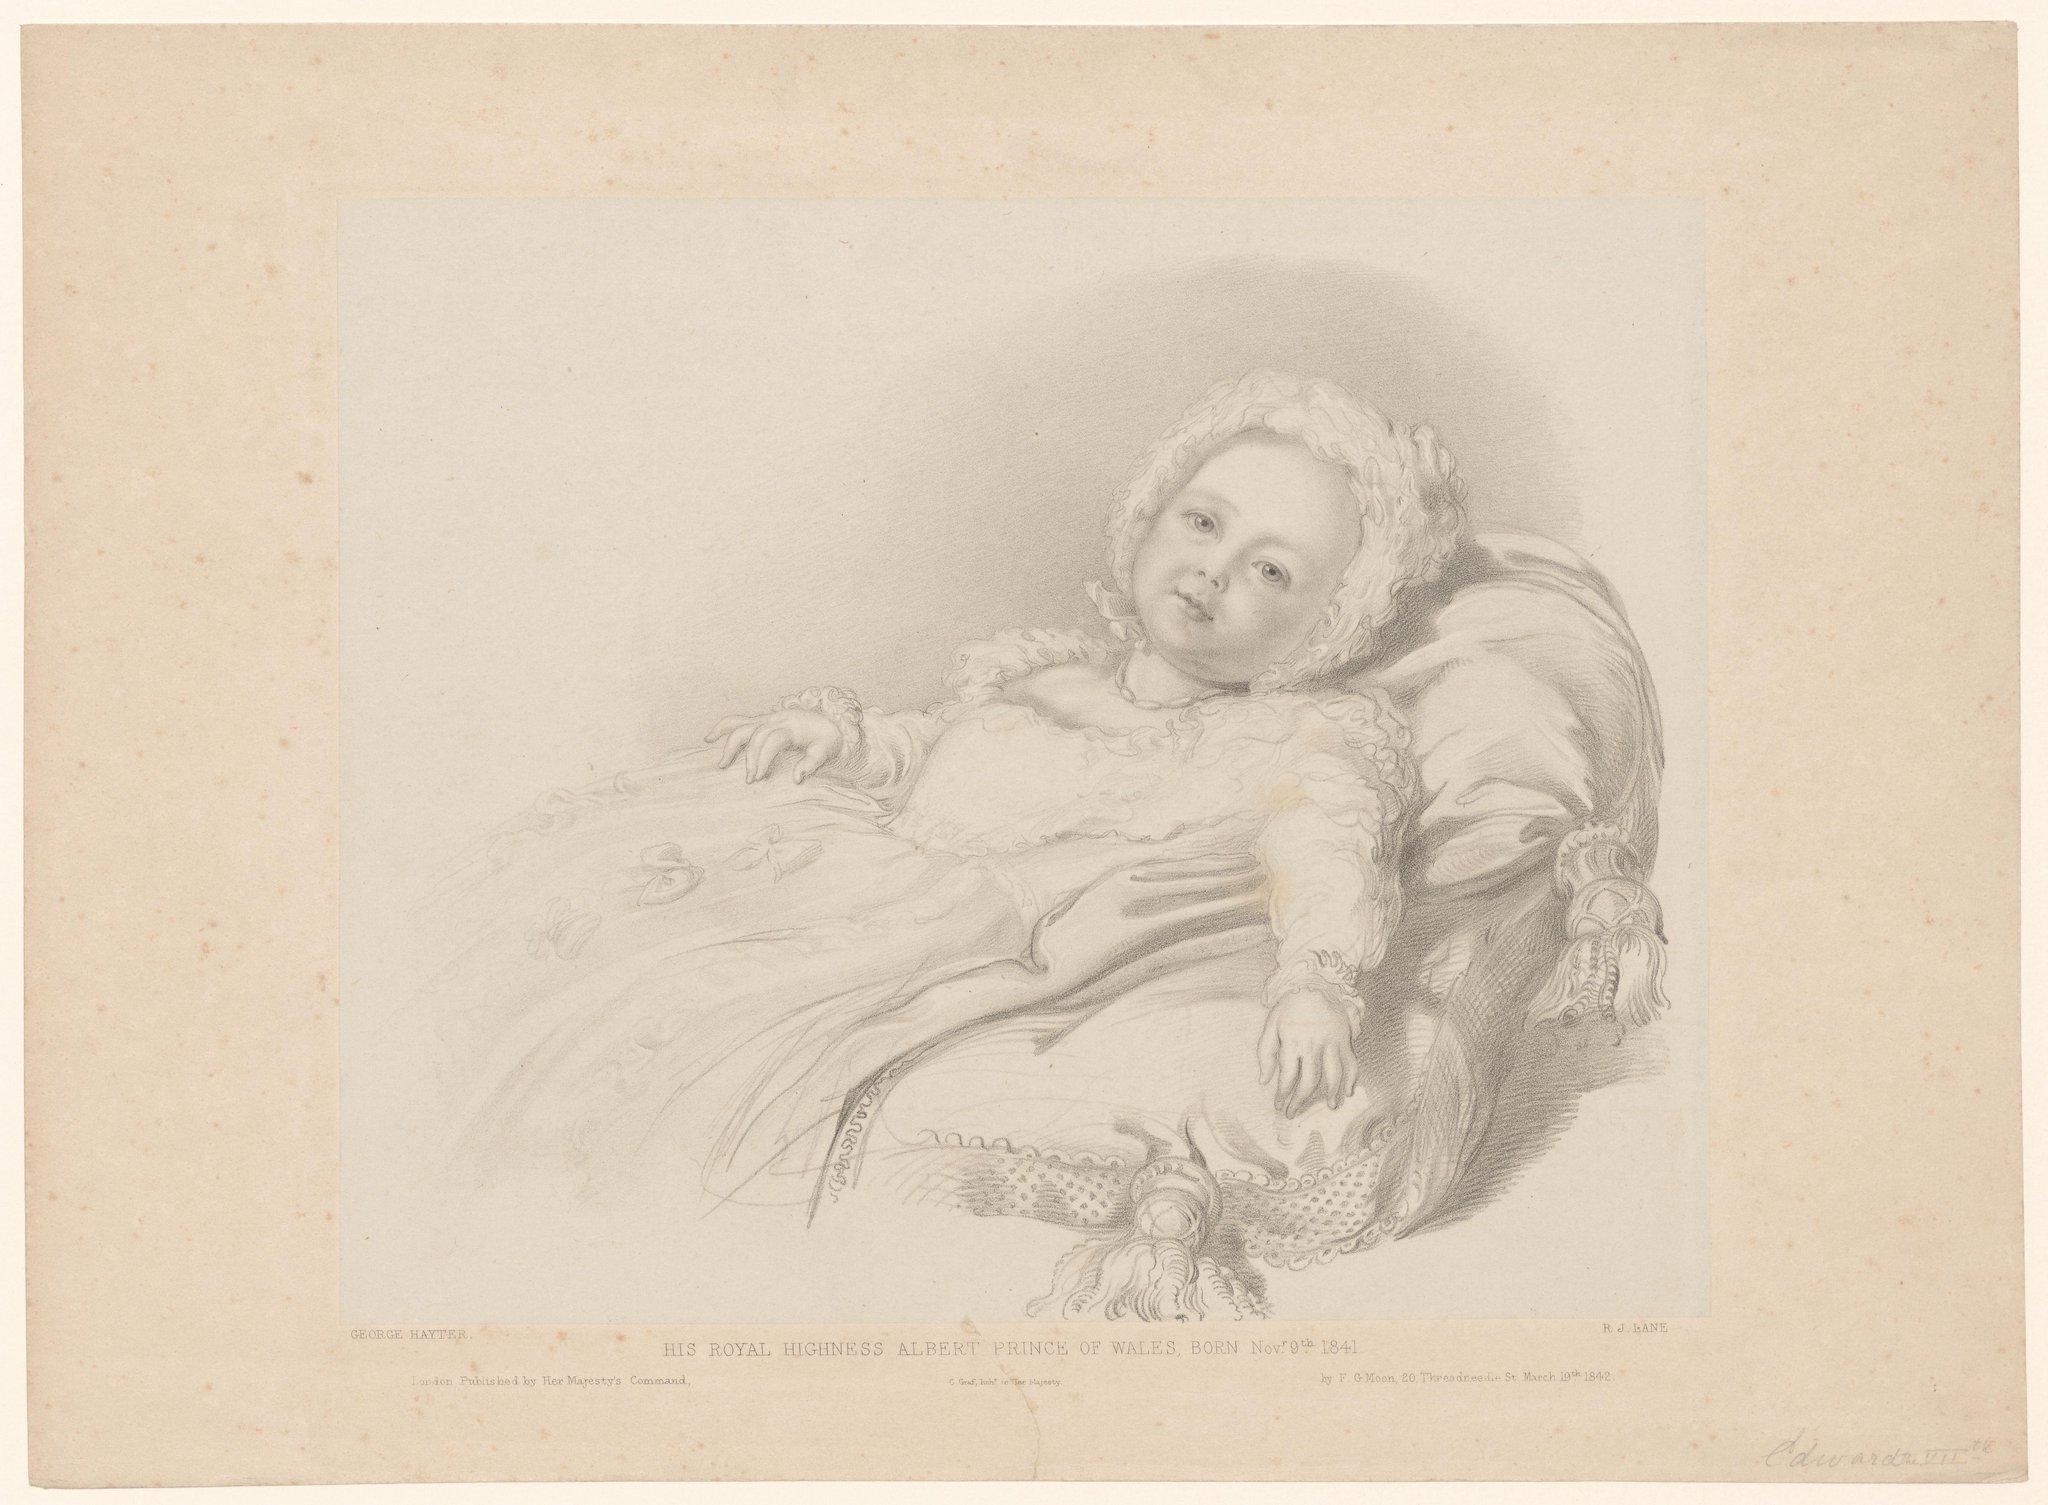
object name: print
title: His royal Highness Albert prince of Wales, born Novr. 9th. 1841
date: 1842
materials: paper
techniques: lithograph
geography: london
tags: london, historical persons, infant, baby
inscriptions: collector's mark: Lugt 2228